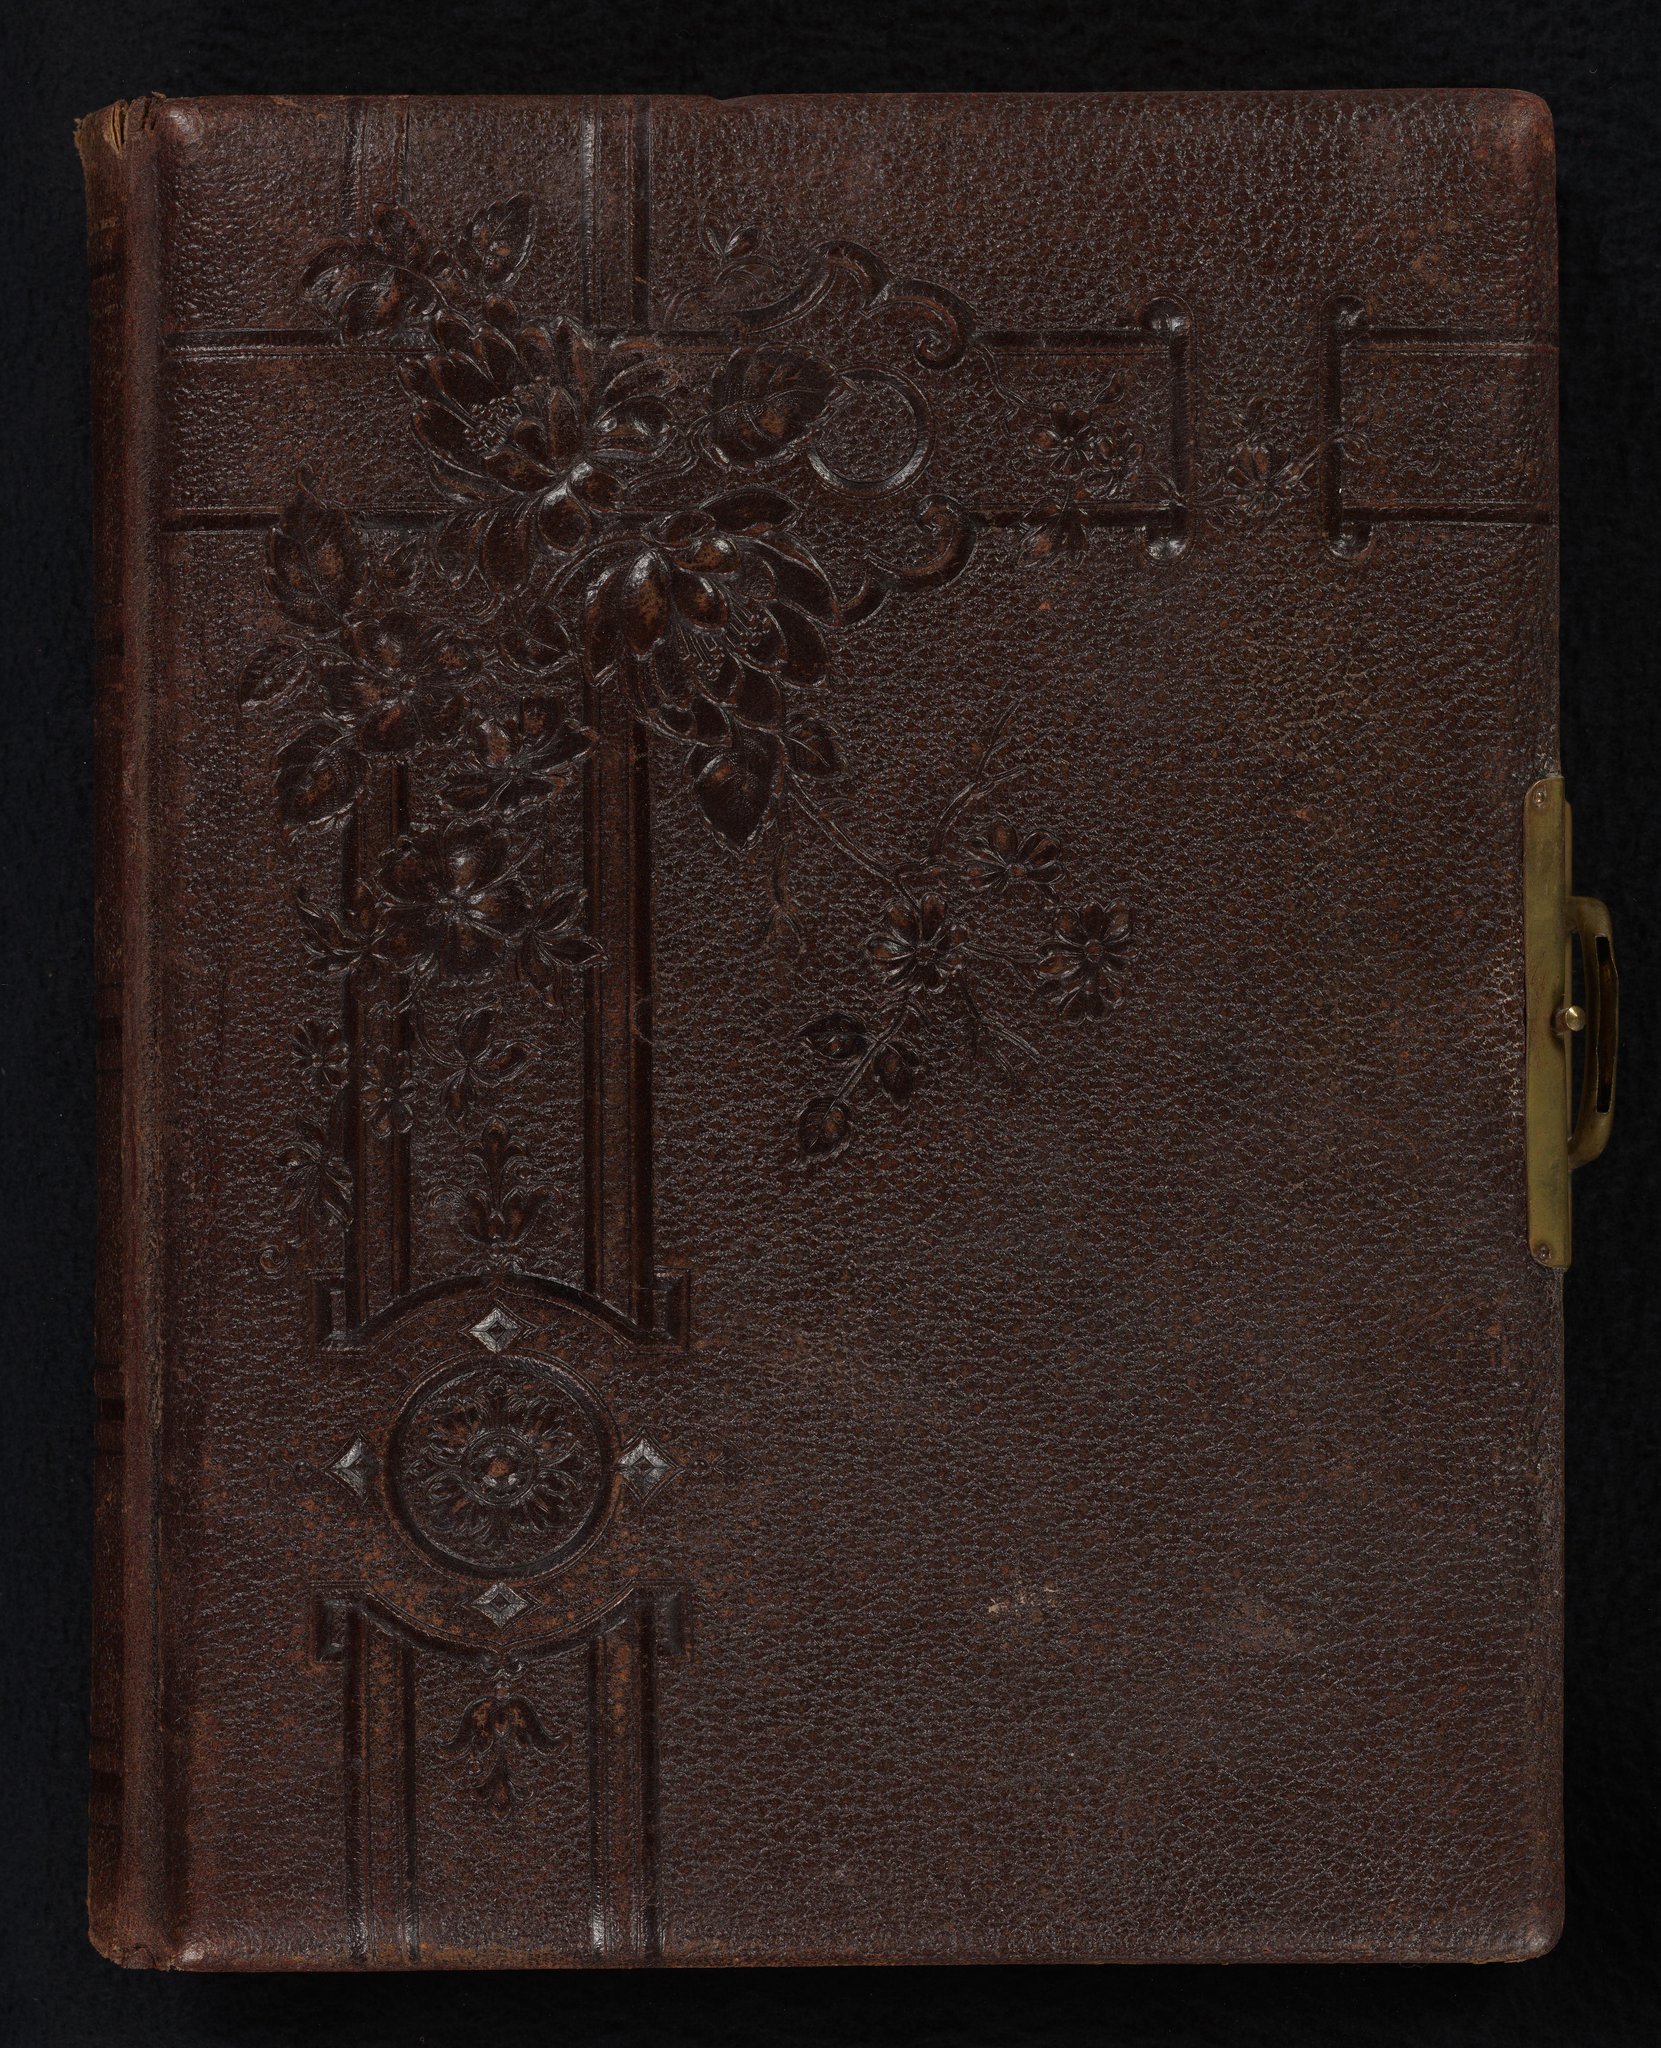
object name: photograph album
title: Engels en Amerikaans familiealbum met speeldoos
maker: Anonymous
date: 1900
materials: cardboard, leather, metal, paper, photographic support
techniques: albumen print, decorated paper, printing block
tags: historical persons - bb - woman, child, historical persons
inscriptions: number: ‘£ 12/10/-’, collector's mark: ‘DIENST/ VERSPREIDE/ RIJKSKOLLEKTIES/ (...) A 1039’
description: Fotoalbum met 15 pagina's met in totaal 30 foto's. Het album bevat 9 kabinetfoto's en 21 cartes-de-visite in passe-partouts omkaderd met gouden lijnen of afbeeldingen van bloemen in cliché. Achterin het album bevindt zich een speeldoos, die met de sluiting kon worden geactiveerd. Afgebeeld zijn portretten van onbekende mannen, vrouwen en kinderen. De foto's zijn gemaakt door diverse fotografen, hoofdzakelijk uit Engeland en Amerika. Van 7 foto's is de fotograaf anoniem.